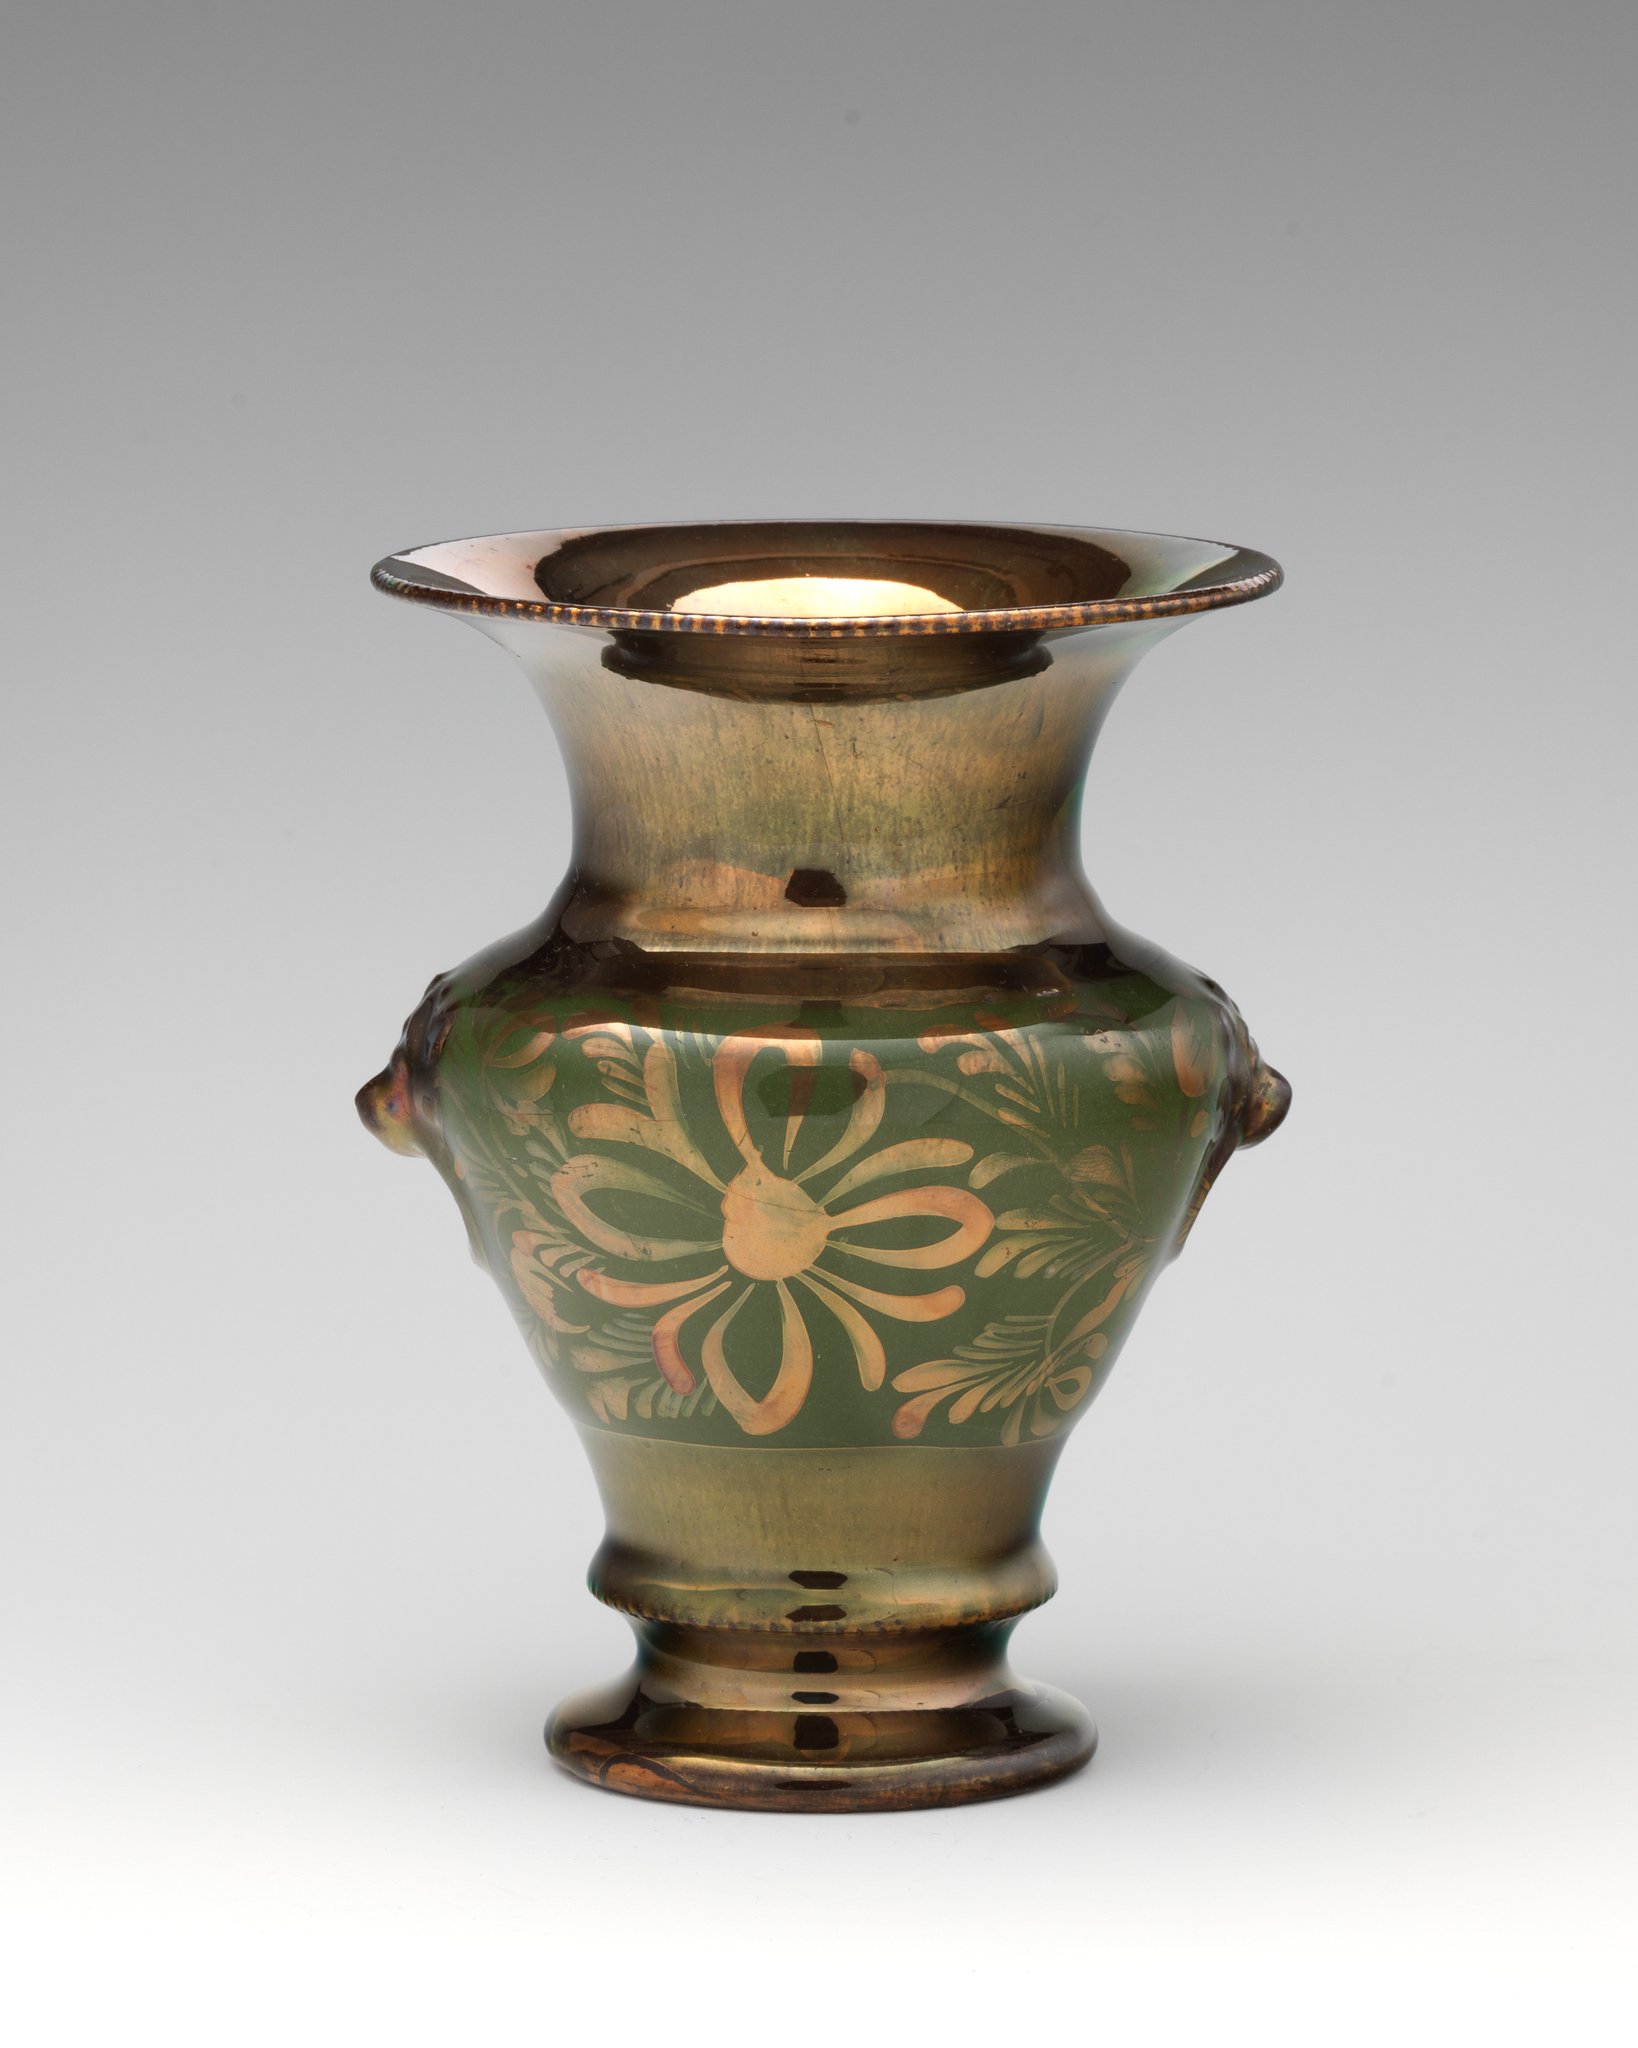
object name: vase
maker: j. gardner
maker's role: maker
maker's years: 1775-1875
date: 1801-1833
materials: pottery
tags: flowers